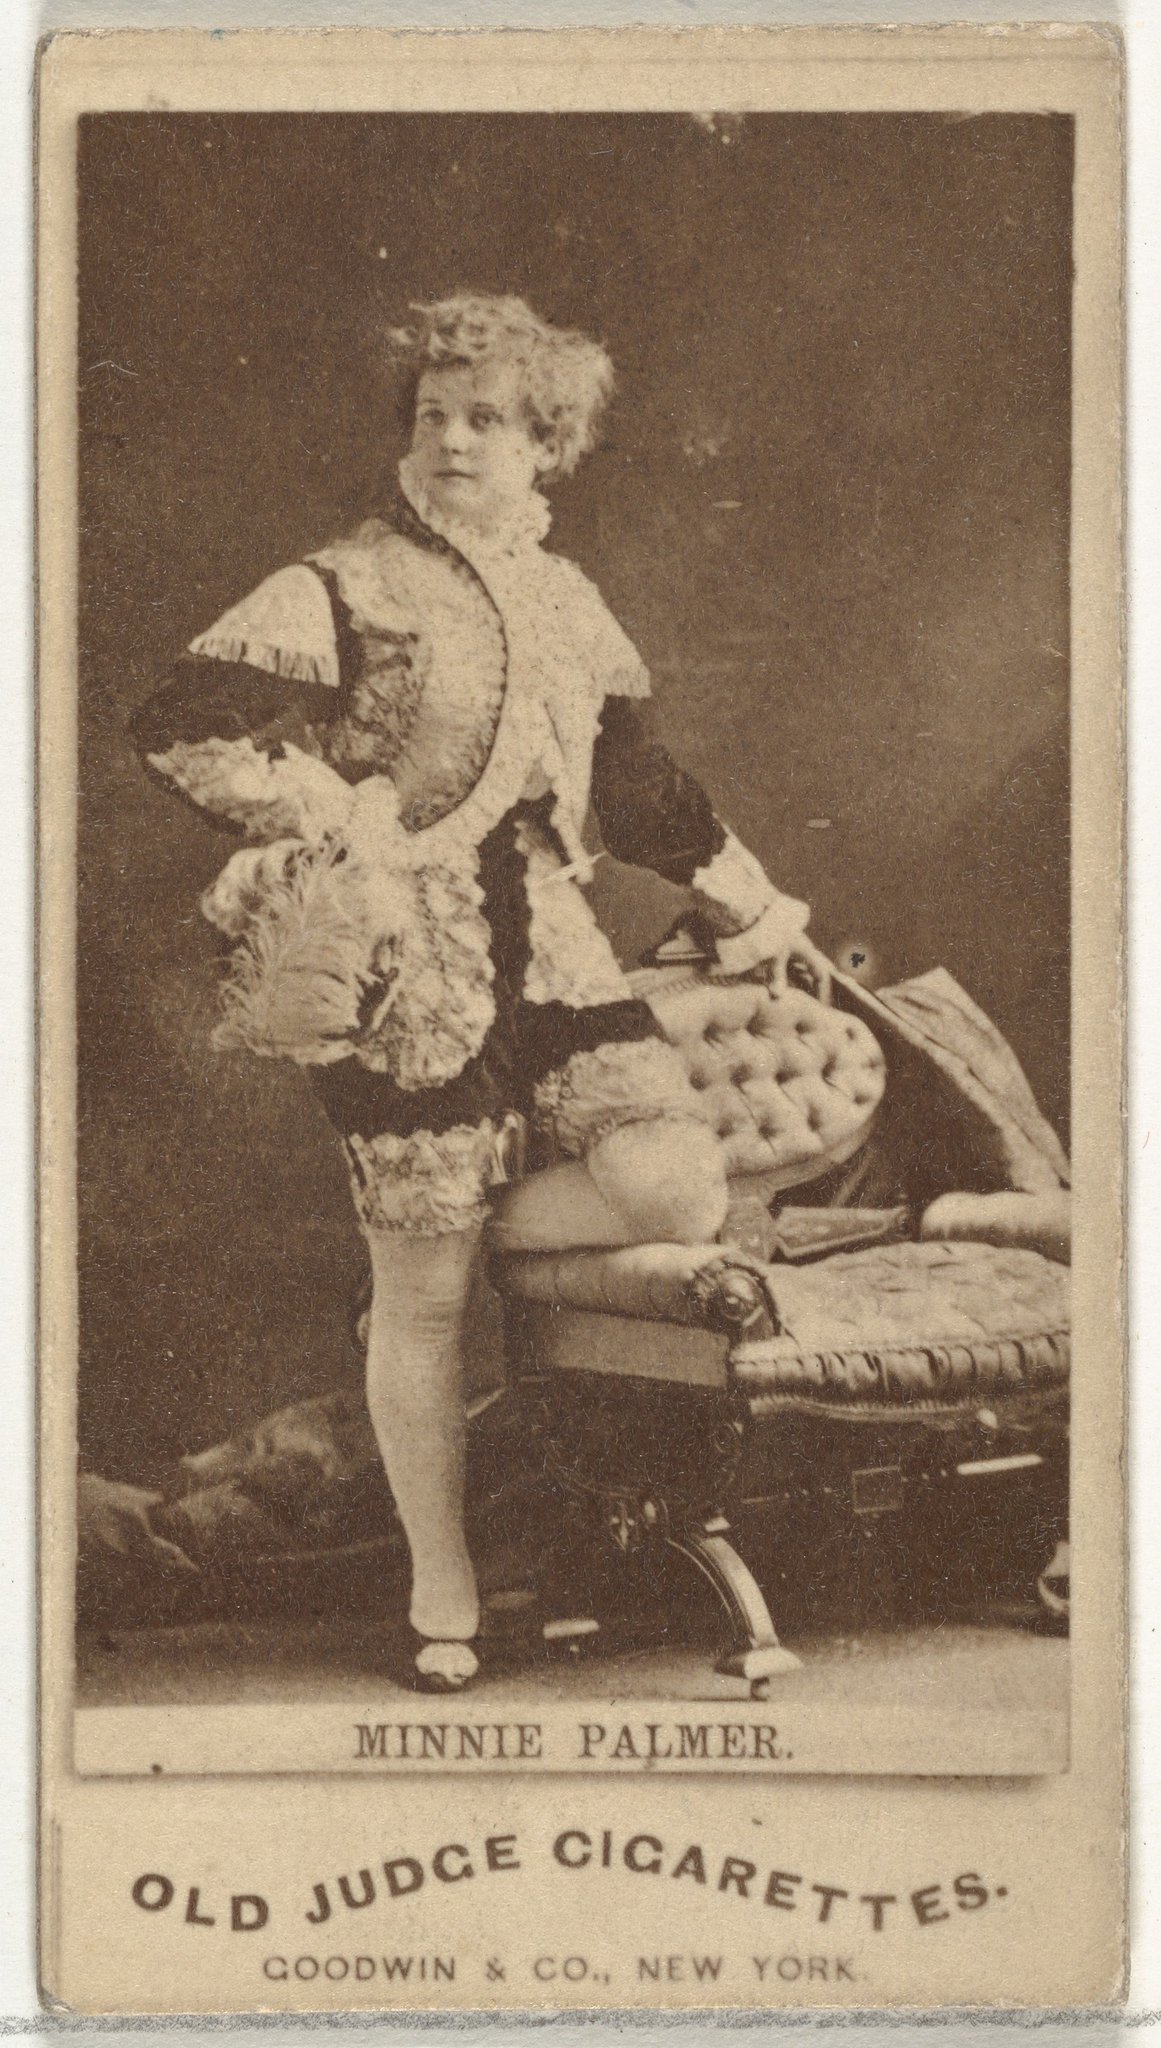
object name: photograph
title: Minnie Palmer, from the Actors and Actresses series (N171) for Old Judge Cigarettes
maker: goodwin & company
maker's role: publisher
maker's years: 1850-1950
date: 1886-1890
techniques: albumen silver print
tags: portraits,women,actresses